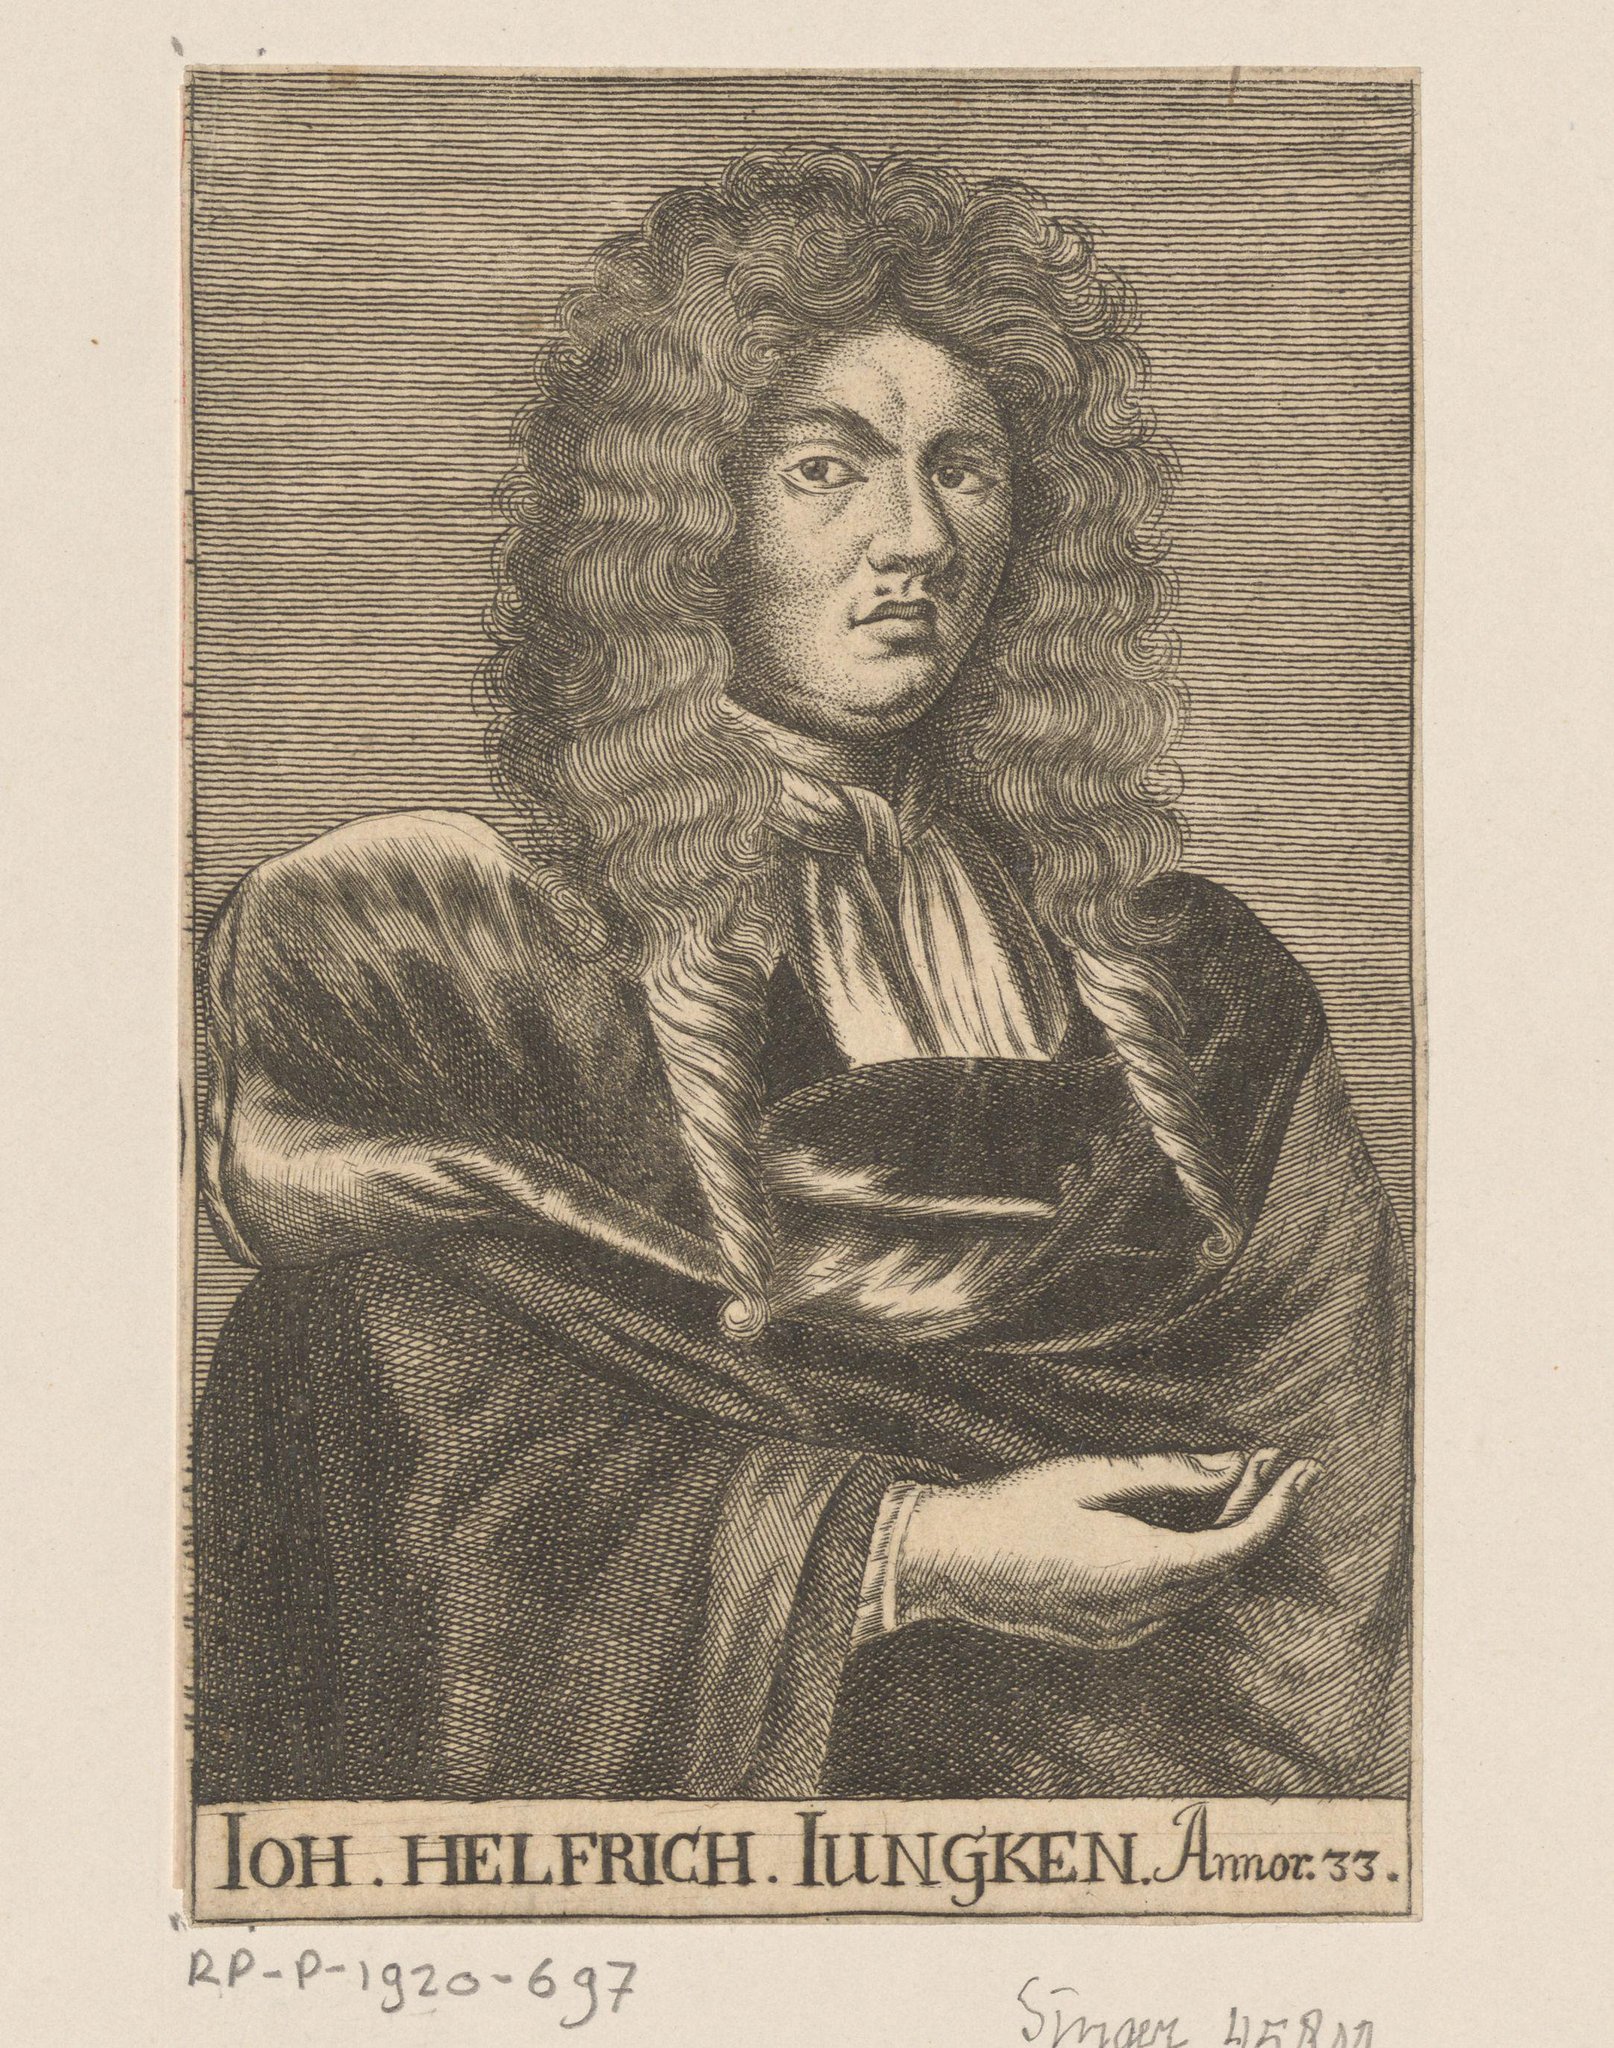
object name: print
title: Portret van Johann Helfrich Jüngken op 33-jarige leeftijd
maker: Anonymous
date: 1689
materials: paper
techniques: engraving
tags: historical persons, physician, doctor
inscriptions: collector's mark: Lugt 2228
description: Prent waarschijnlijk uit: Jüngken, Johann Helfrich. Joh. Helfrici Jungkens pedicus praesenti seculo accommodandus, per philosophiam veram spagiricam rerum (...). Frankfurt am Main: Albert Otto Faber, 1689.